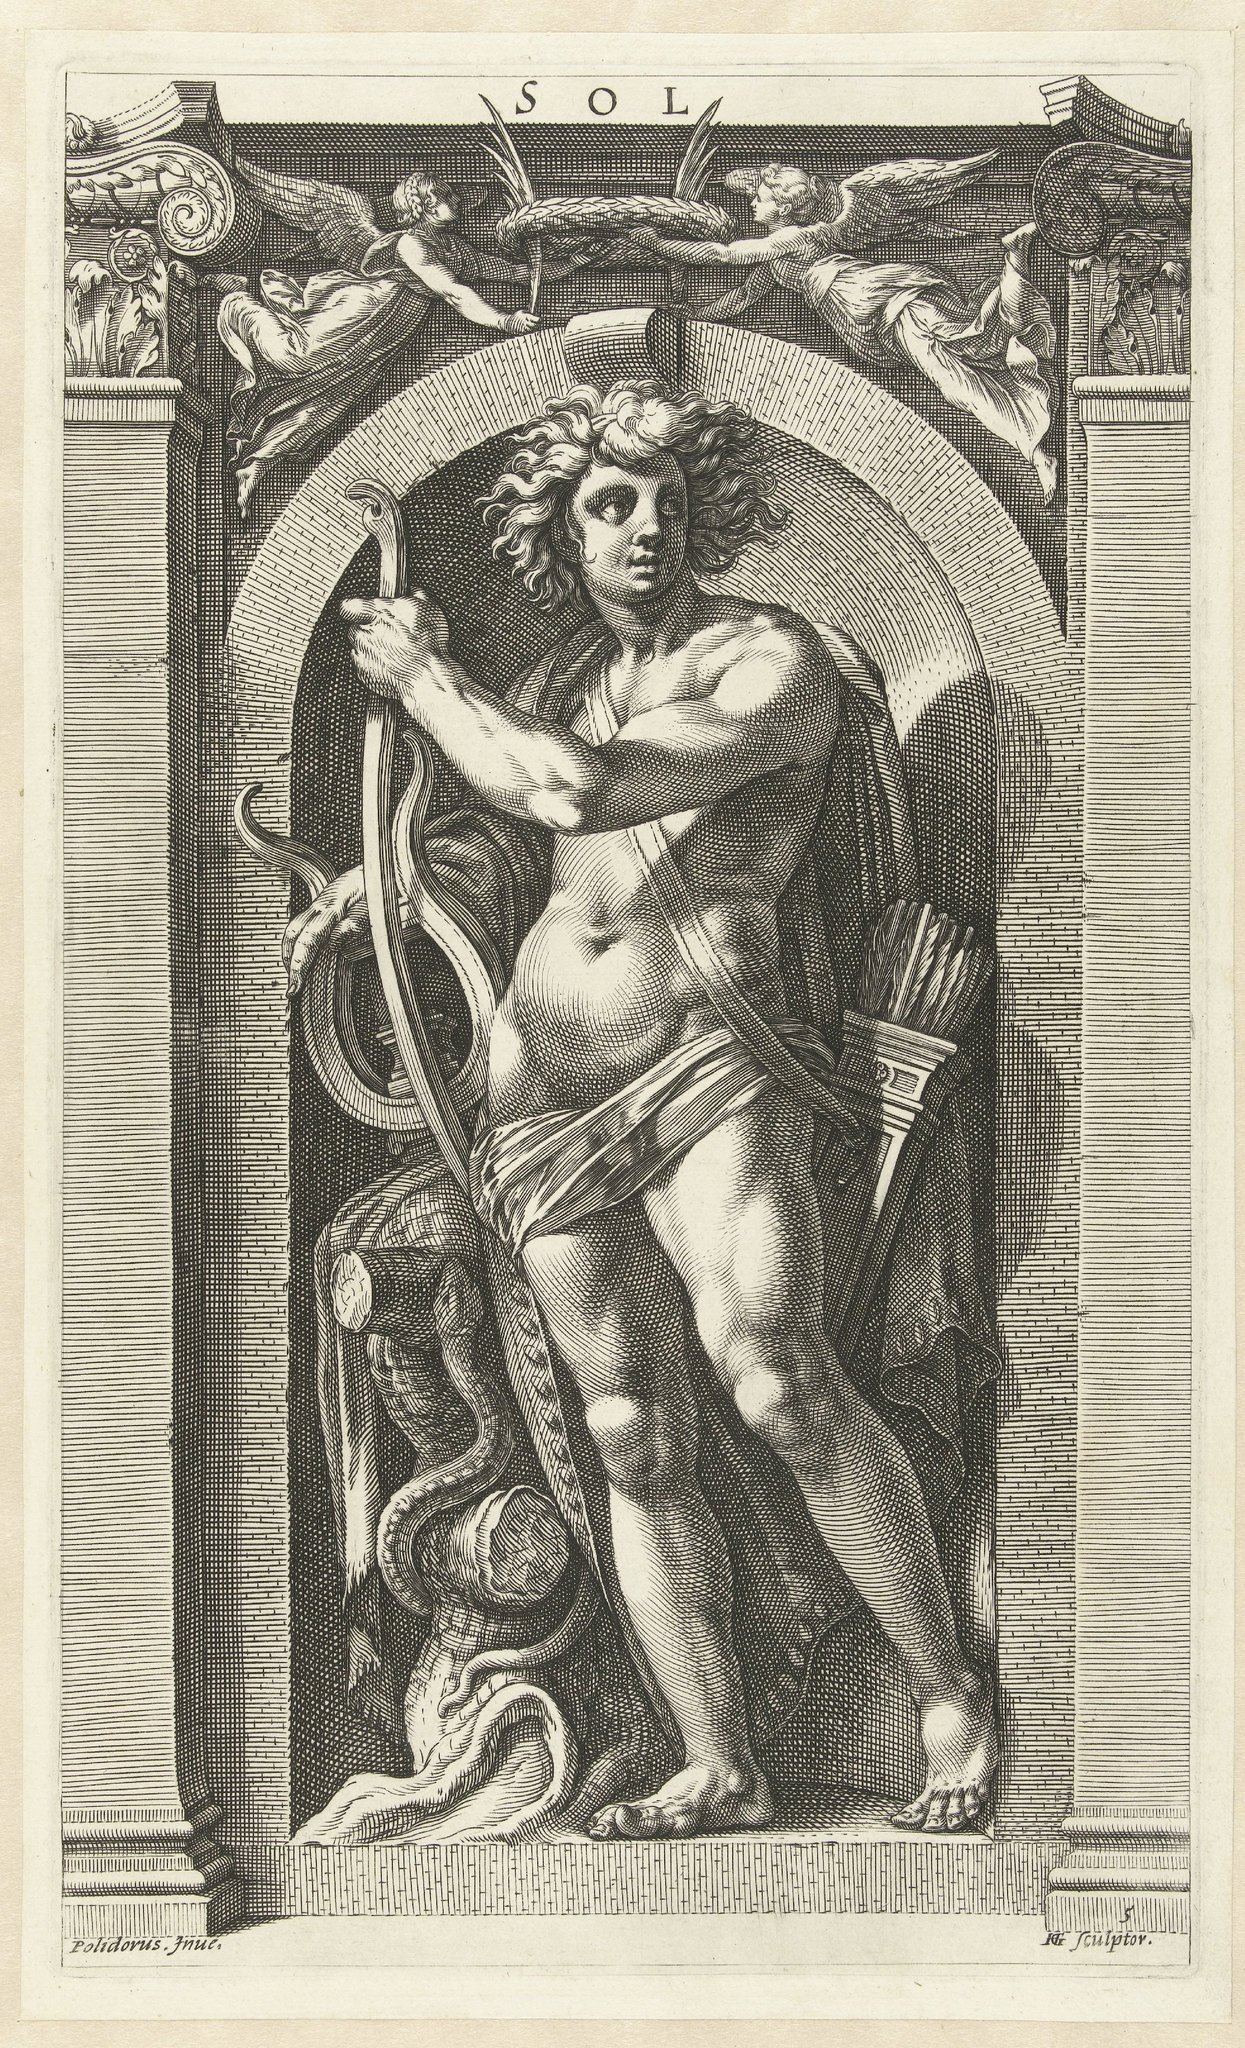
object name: print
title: Sol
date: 1592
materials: paper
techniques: engraving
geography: haarlem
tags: apollo as sun-god, i.e. sol (helius), titan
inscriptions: collector's mark: Lugt 240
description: Sol, staand in een nis, een lier in zijn rechterhand, een boog in zijn linkerhand, over zijn schouder een koker met pijlen. Deze prent is onderdeel van een serie van acht prenten van klassieke goden, gebaseerd op schilderingen van Polidoro da Caravaggio op de façade van een Romeins huis, door Goltzius in Rome gezien en nagetekend.